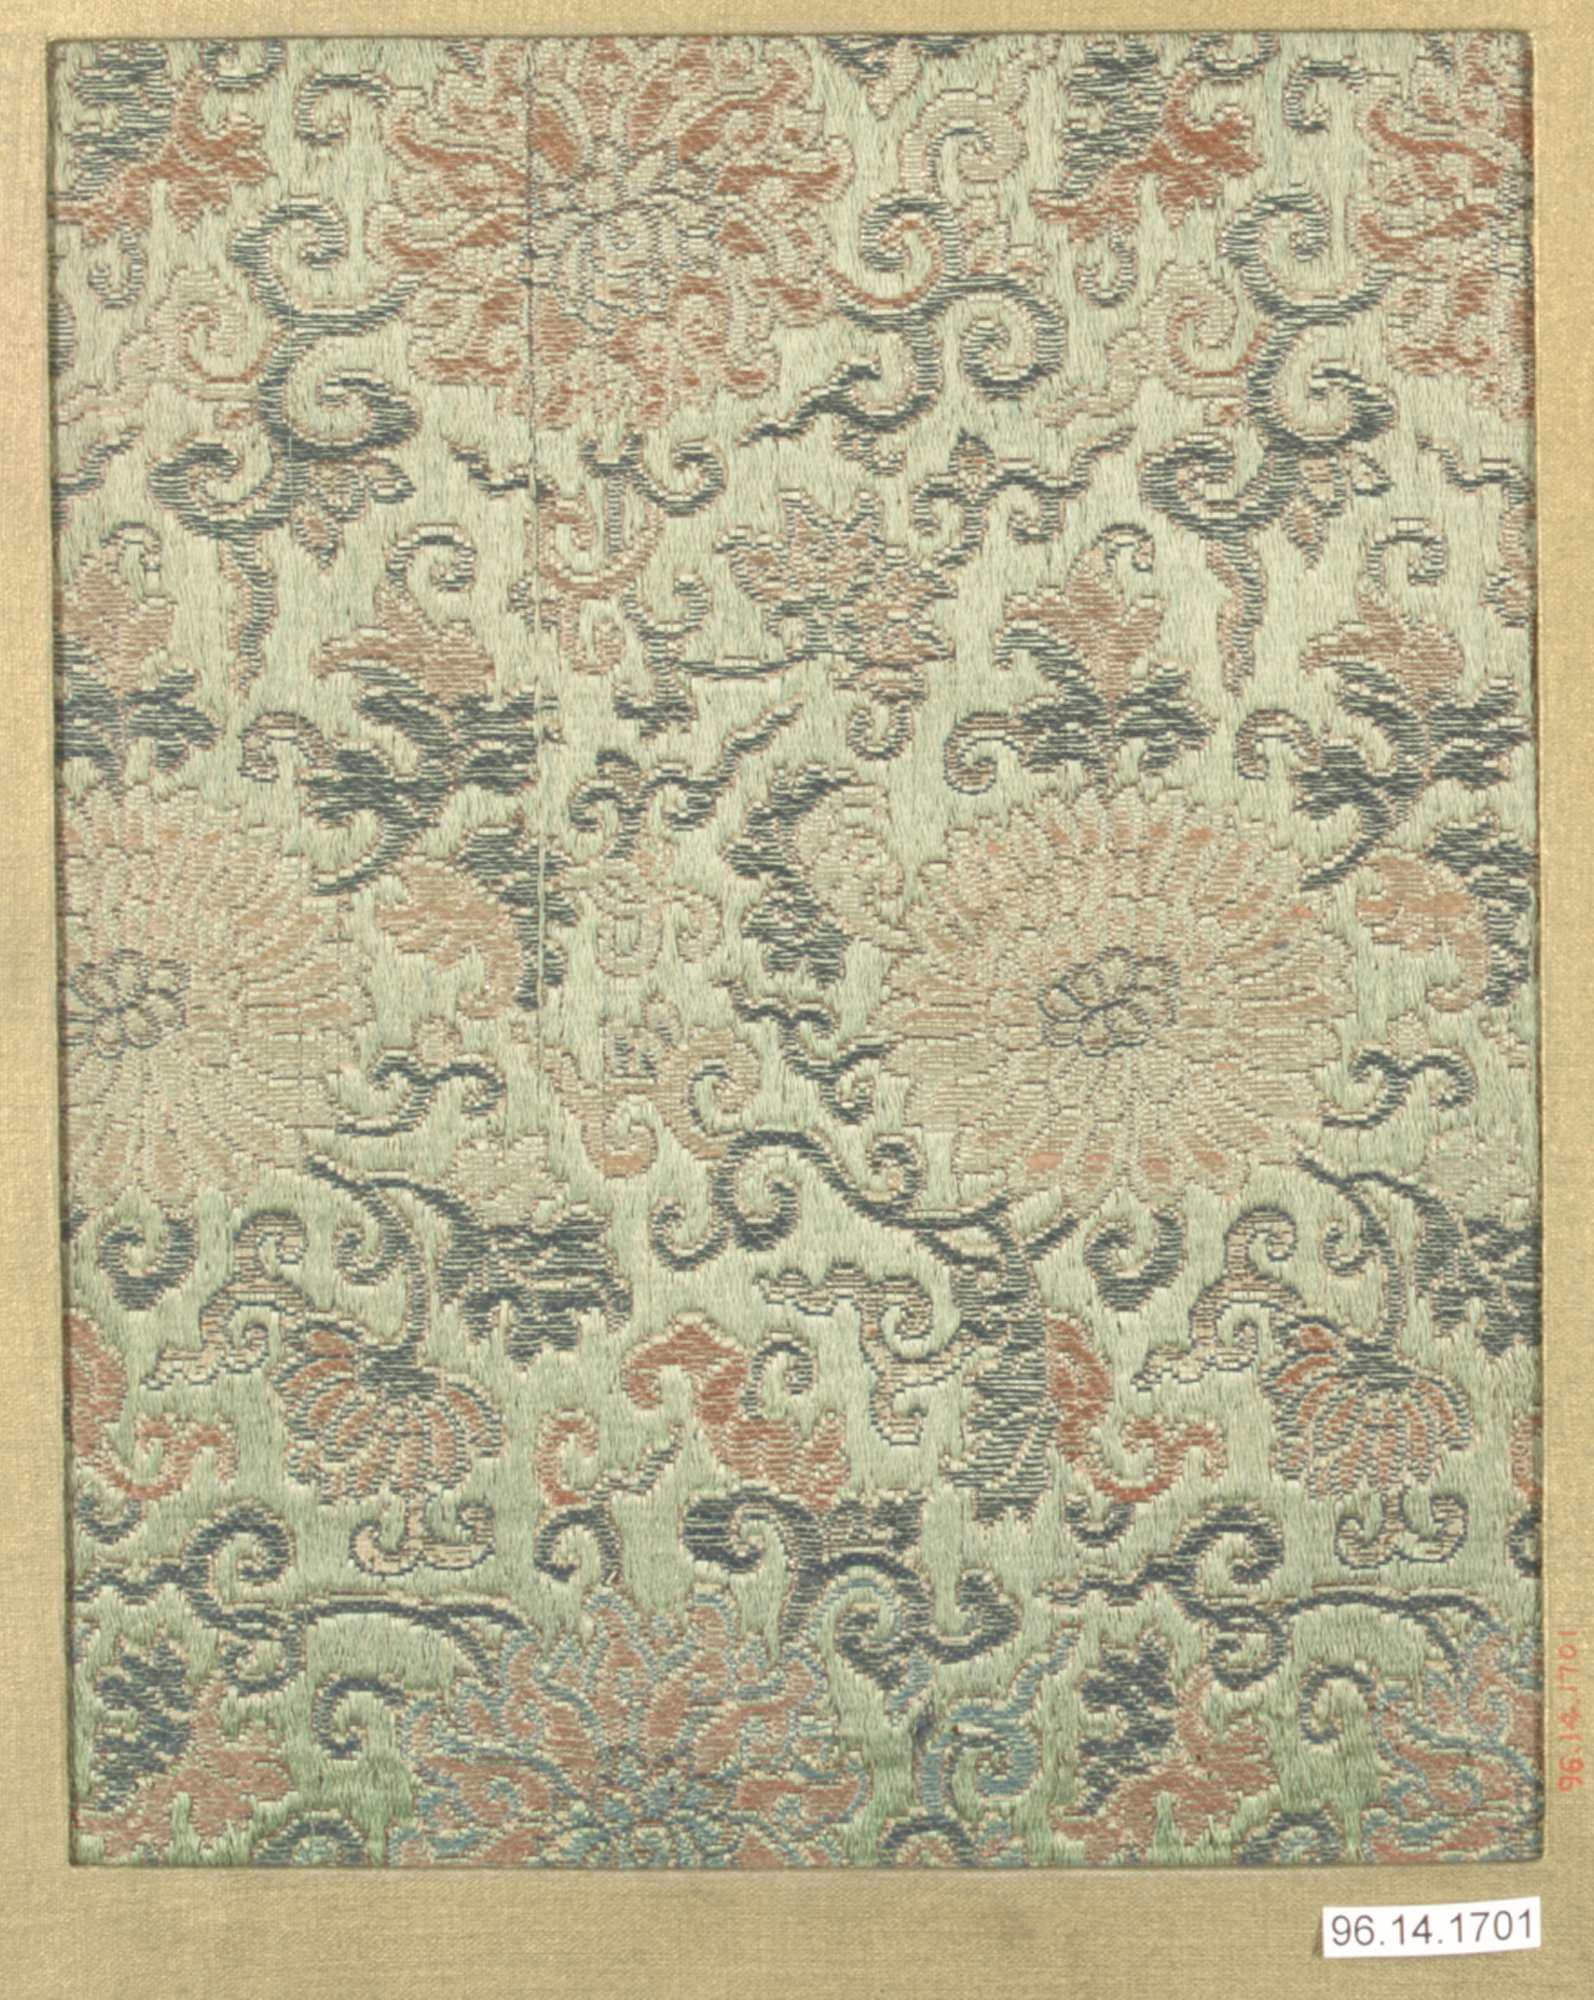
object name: piece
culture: japanese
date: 1701-1900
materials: silk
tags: flowers